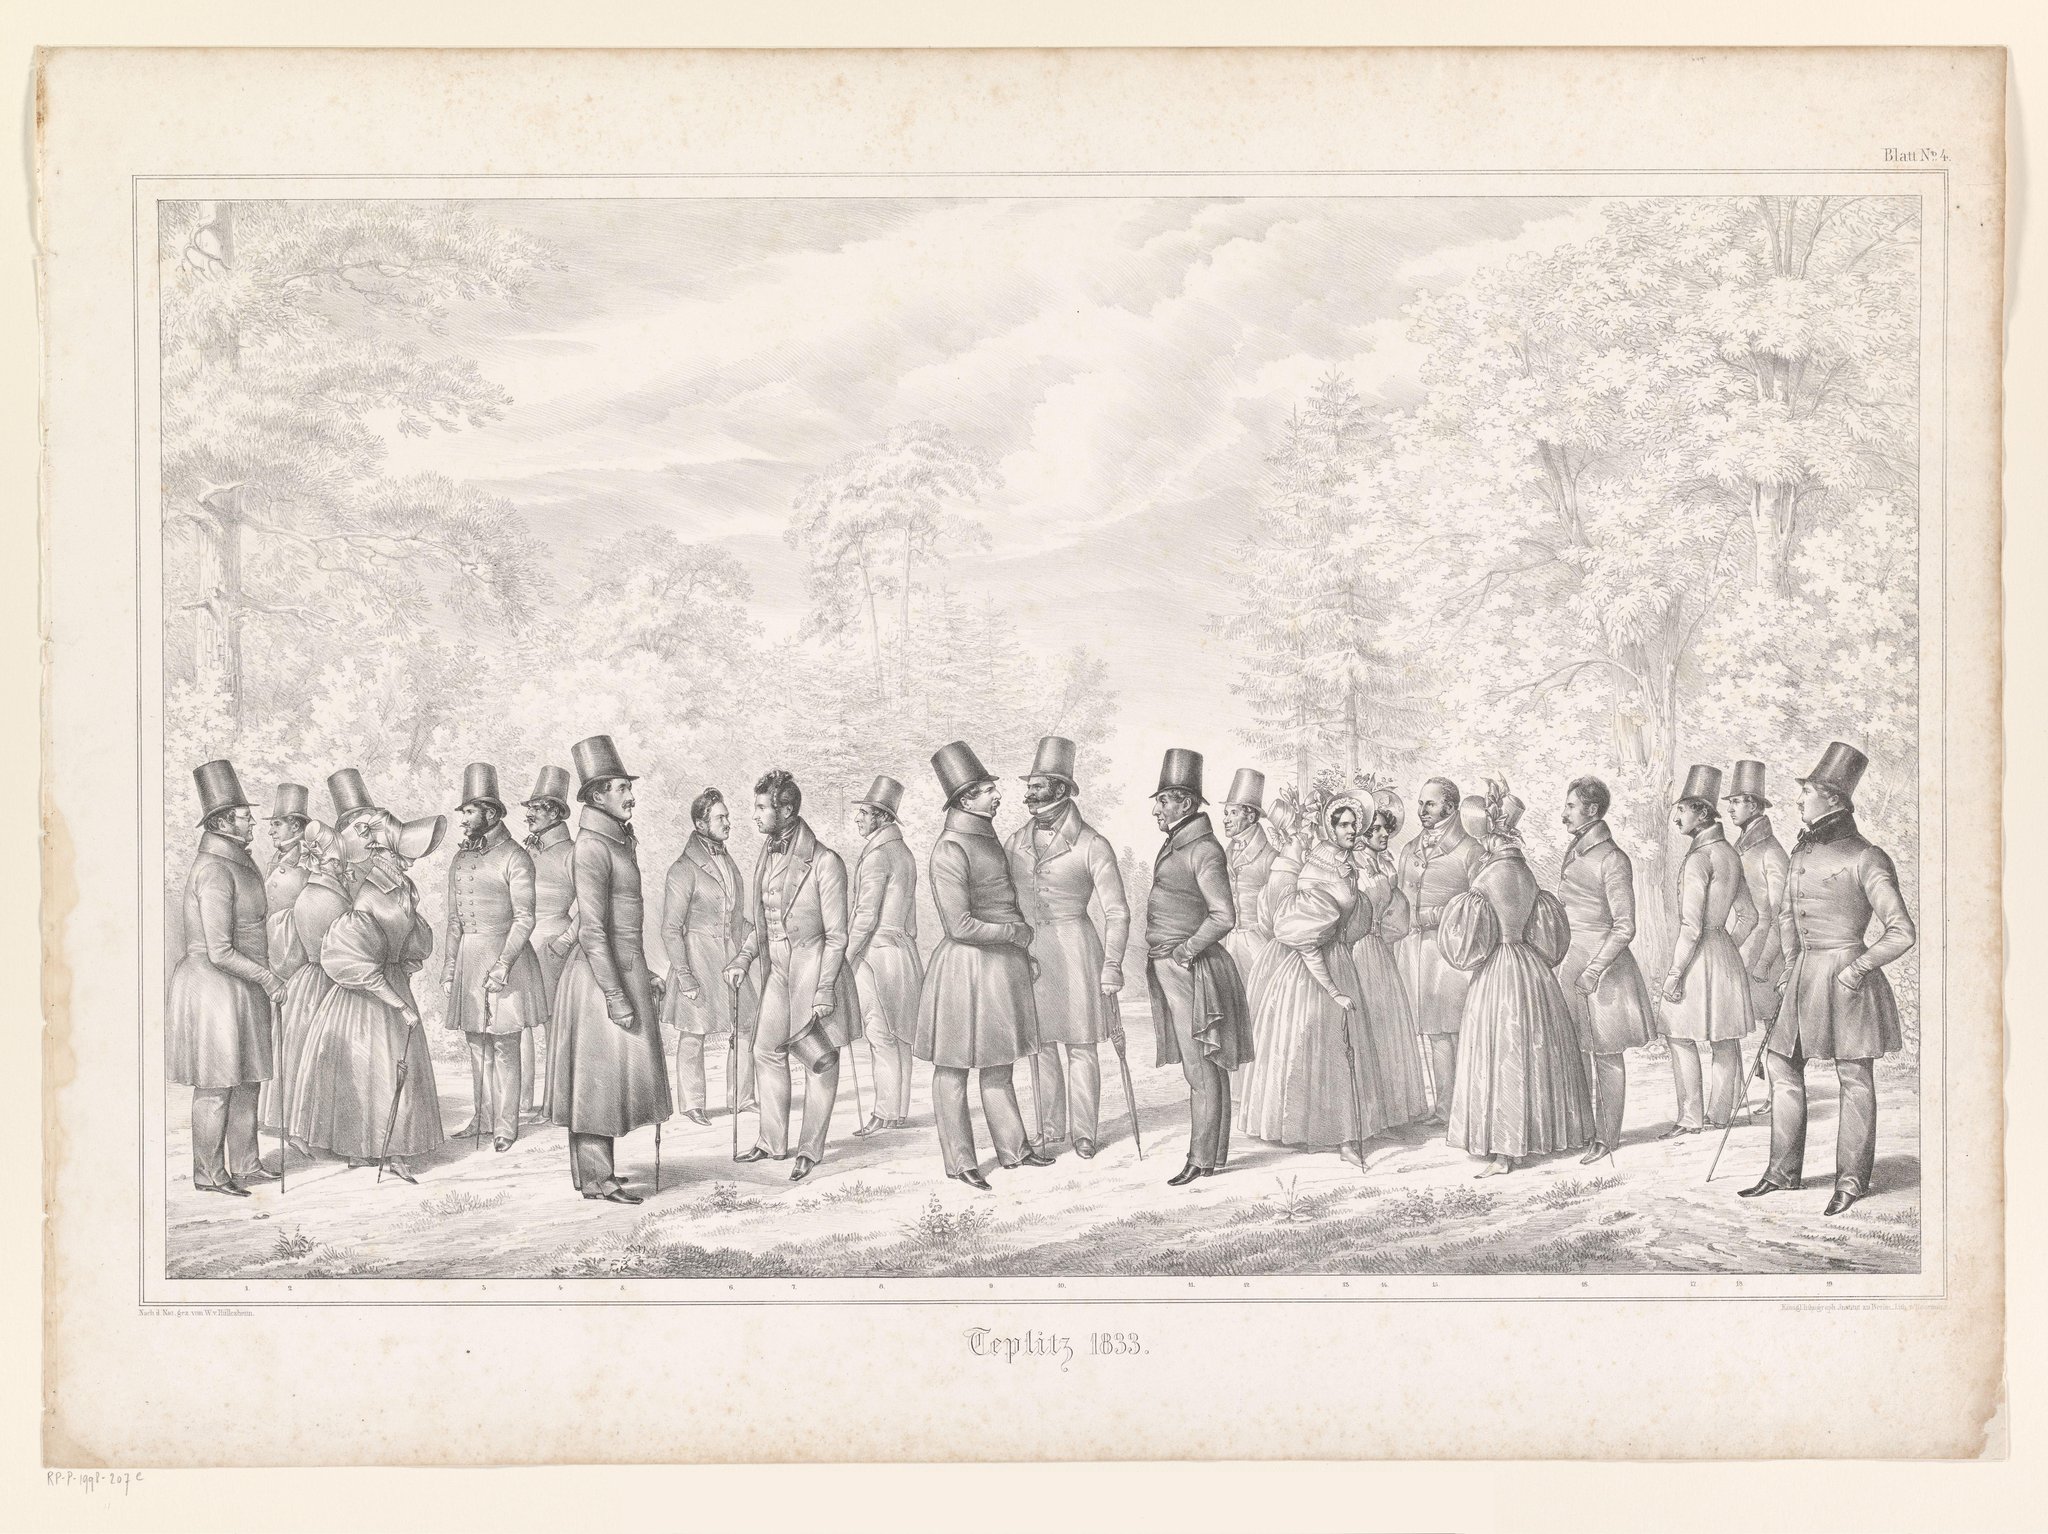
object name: print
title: Erinnerung an Teplitz, Bade Saison 1833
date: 1833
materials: paper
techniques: lithograph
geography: germany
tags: adult man (+ more than eight persons), adult woman (+ six persons), historical persons, landscapes (+ landscape with figures, staffage), anonymous historical persons portrayed in a group, in a group-portrait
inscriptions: collector's mark: Lugt 2228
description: Portretten van baron Von Gilgenheimb, Von Hodenius, baron von Gruben, Von Ehrenstein, Hasslinger, baron von Bilderling, Von Blankensee, Minto, Wilhelm Radziwil, Stroganoff, Metternich, Heijde, Stroganoff, Gary und Aldringer, Ancillon, Von Thümen, baron Von Kaulbars, Von Kessel en Von Bonin.